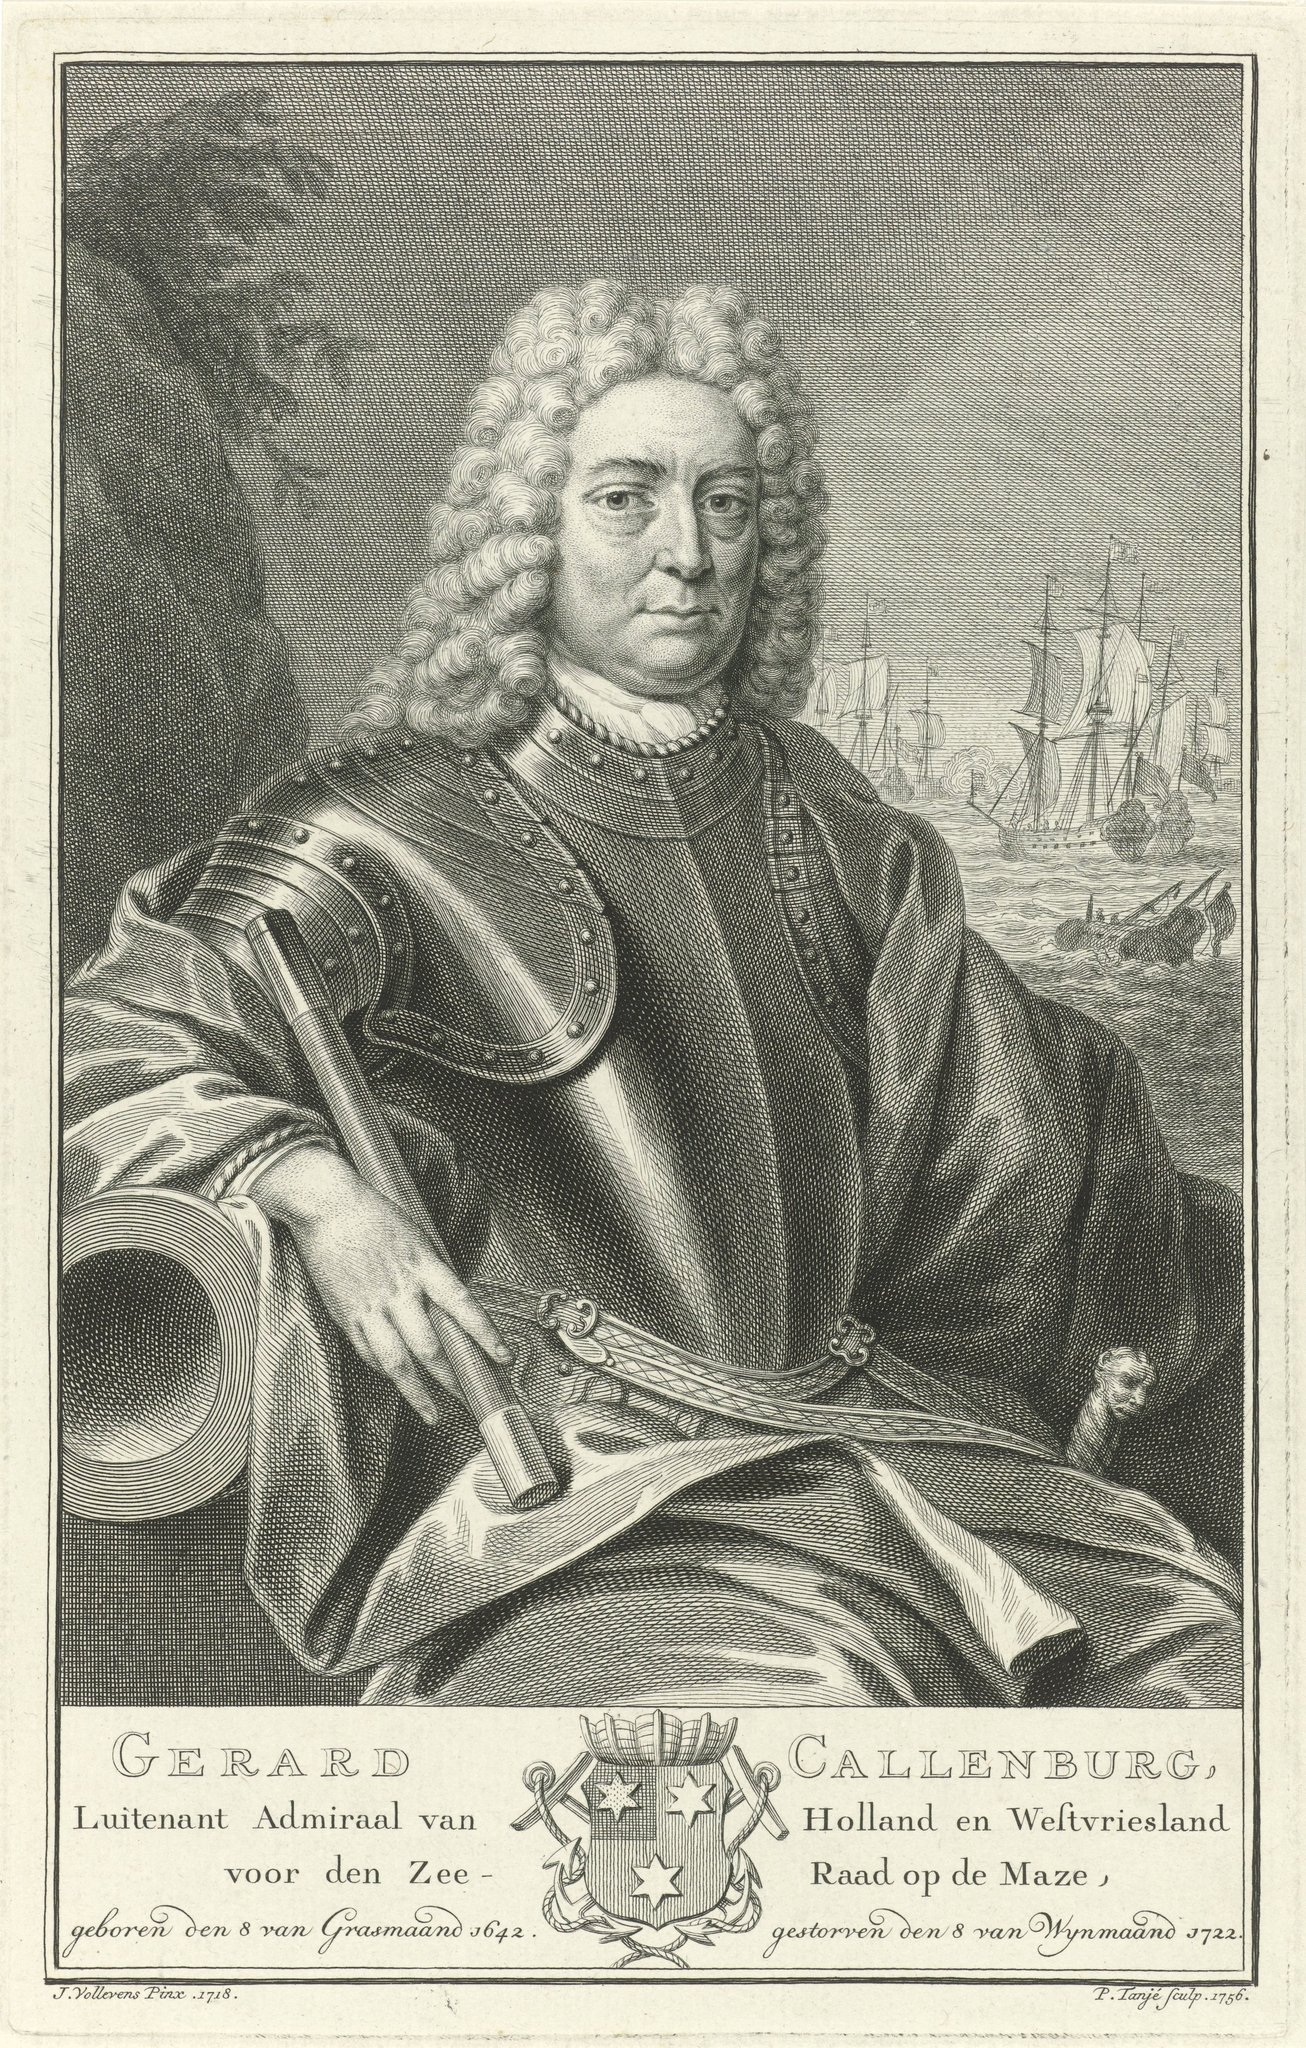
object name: print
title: Portret van Gerard Callenburgh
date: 1756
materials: paper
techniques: engraving, etching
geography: amsterdam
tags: flushing, gerard callenburgh, sailing-ship, sailing-boat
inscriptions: collector's mark: Lugt 240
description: Portret van Gerard Callenburgh, luitenant-admiraal van Holland en West-Friesland, met de bevelhebberstaf in zijn hand. Op de achtergrond schepen op zee. Midden onder in de marge zijn wapenschild.